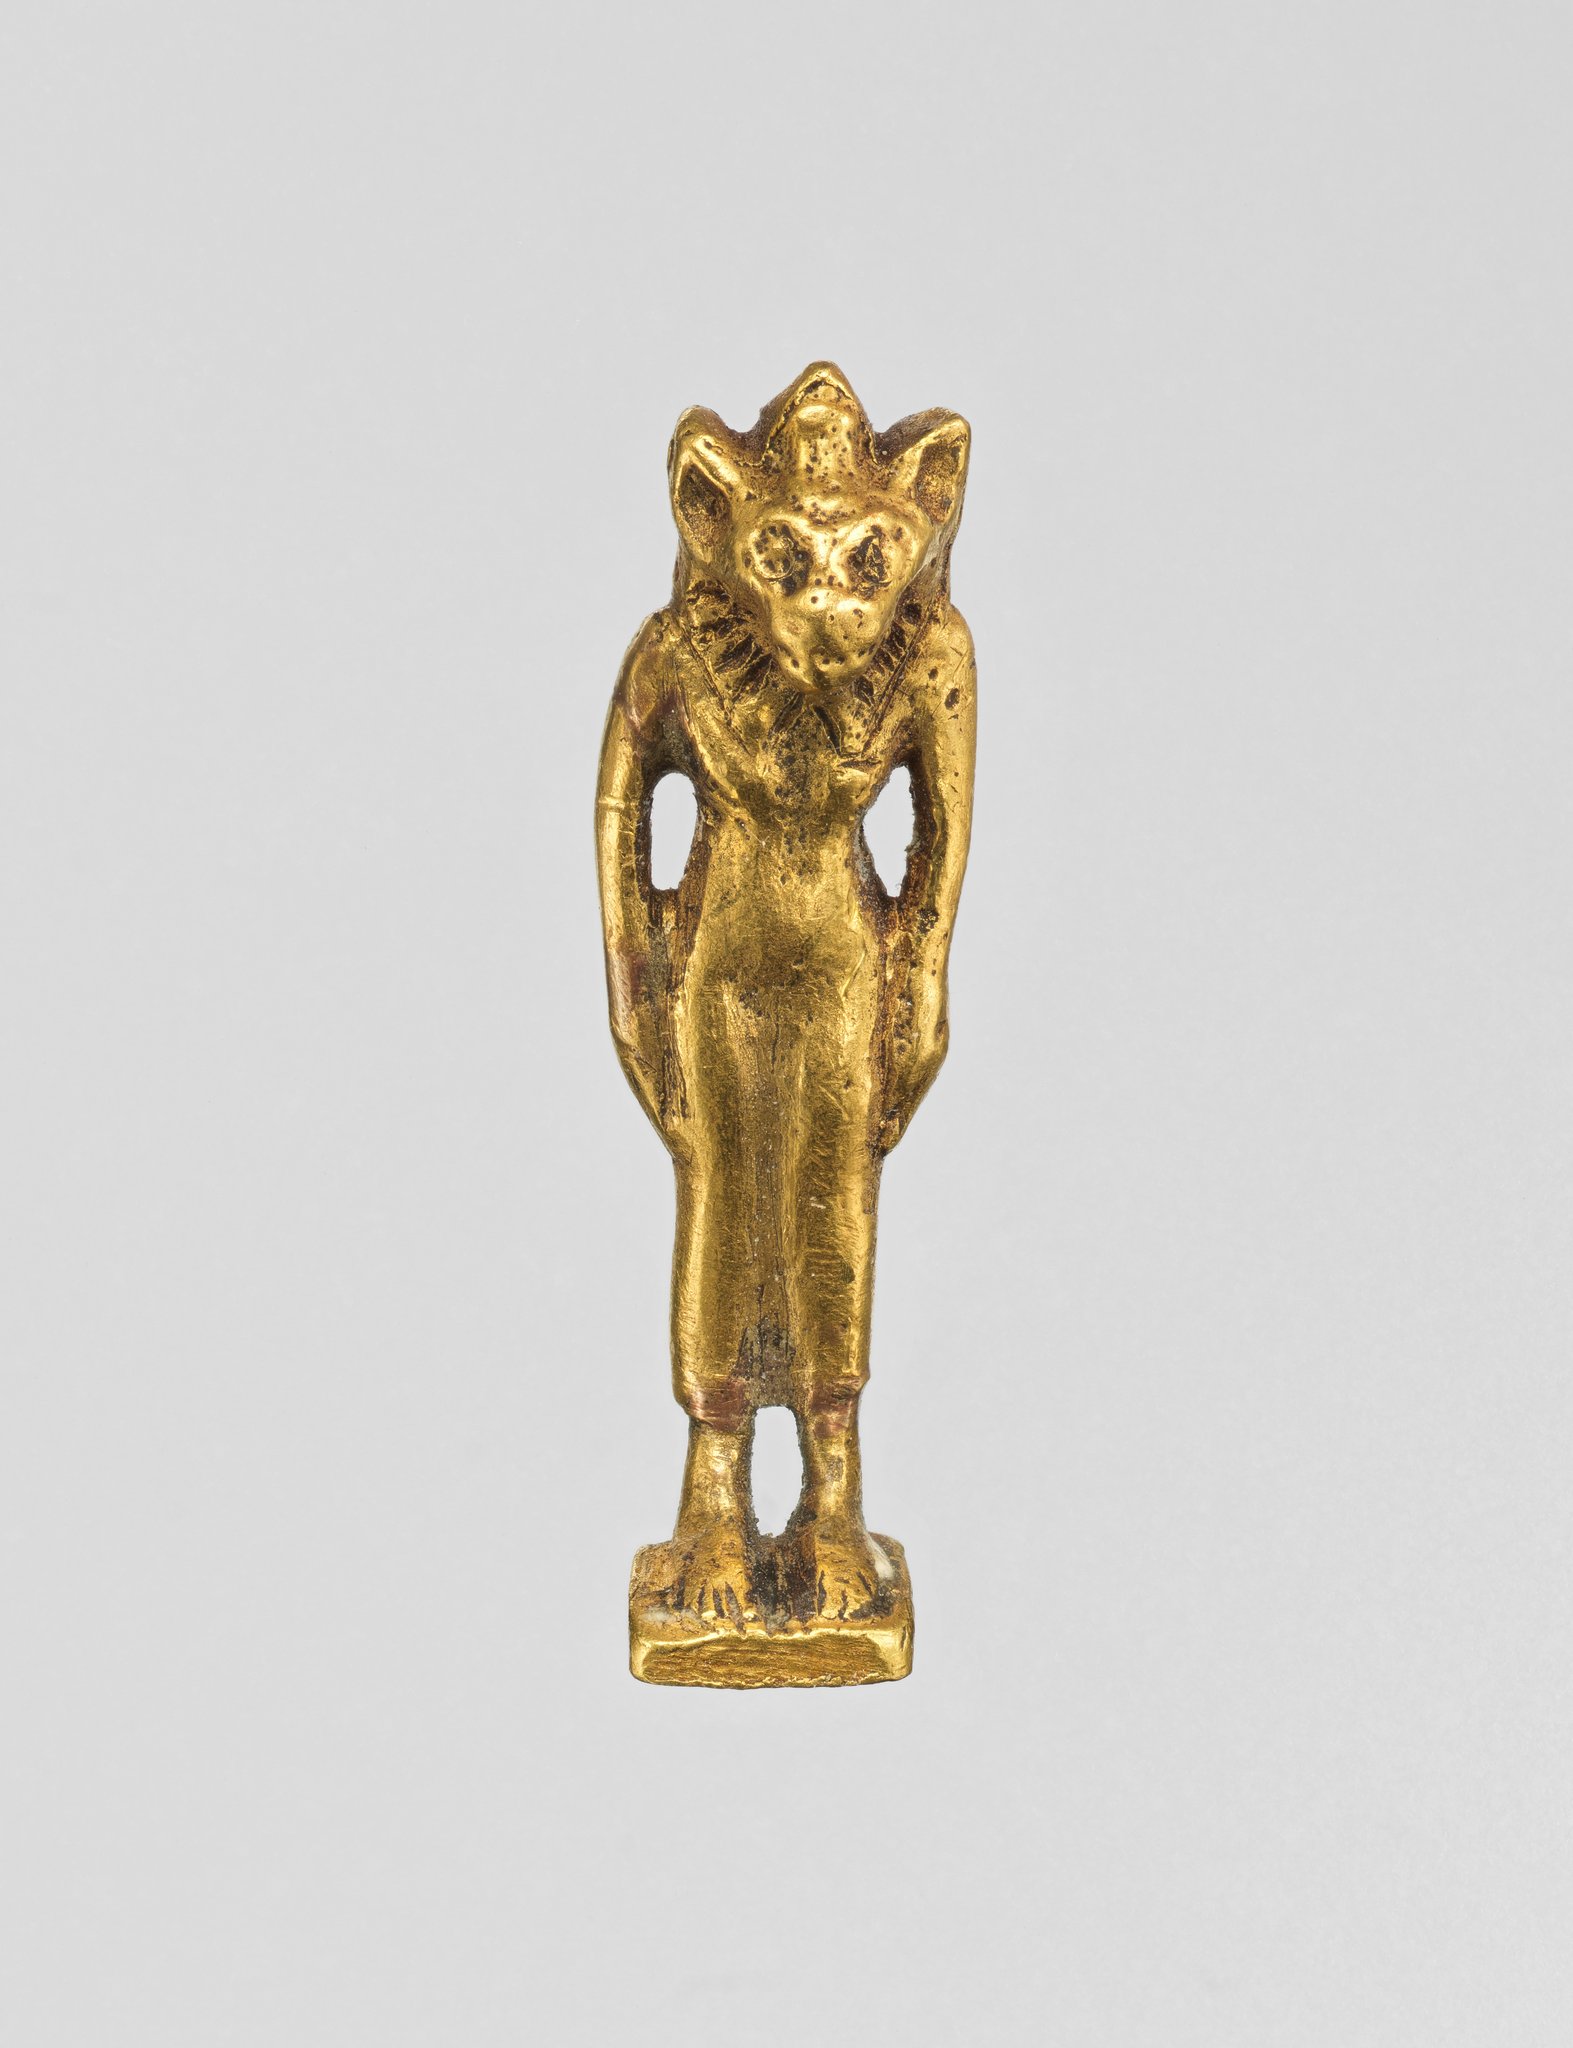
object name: amulet pendant, genius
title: Amulet pendant, genii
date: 332-330 BCE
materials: gold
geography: egypt